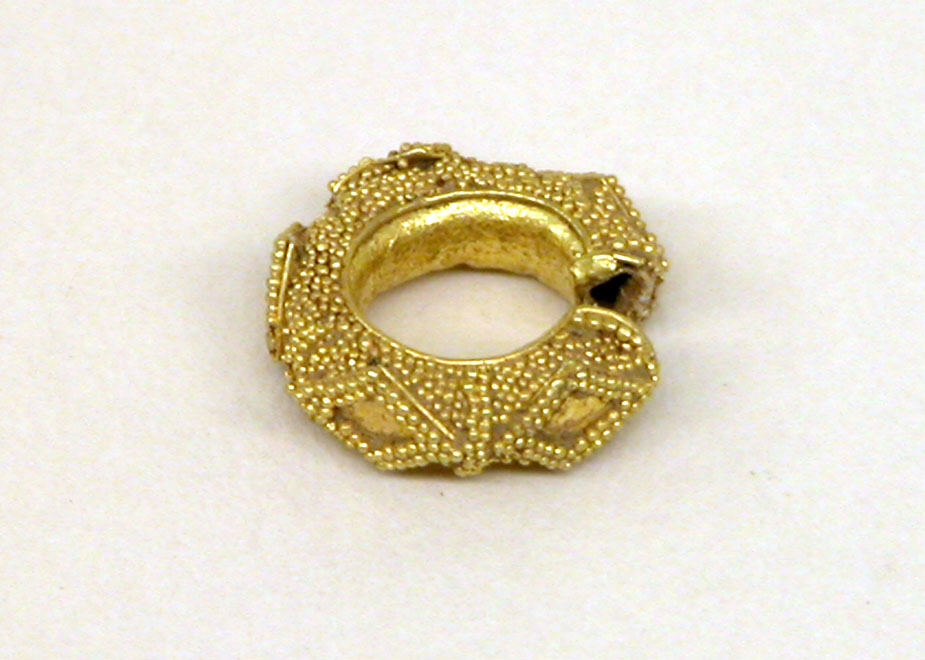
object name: ear ornament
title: Ear Ornament with Granulate Design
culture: indonesian, javanese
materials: gold